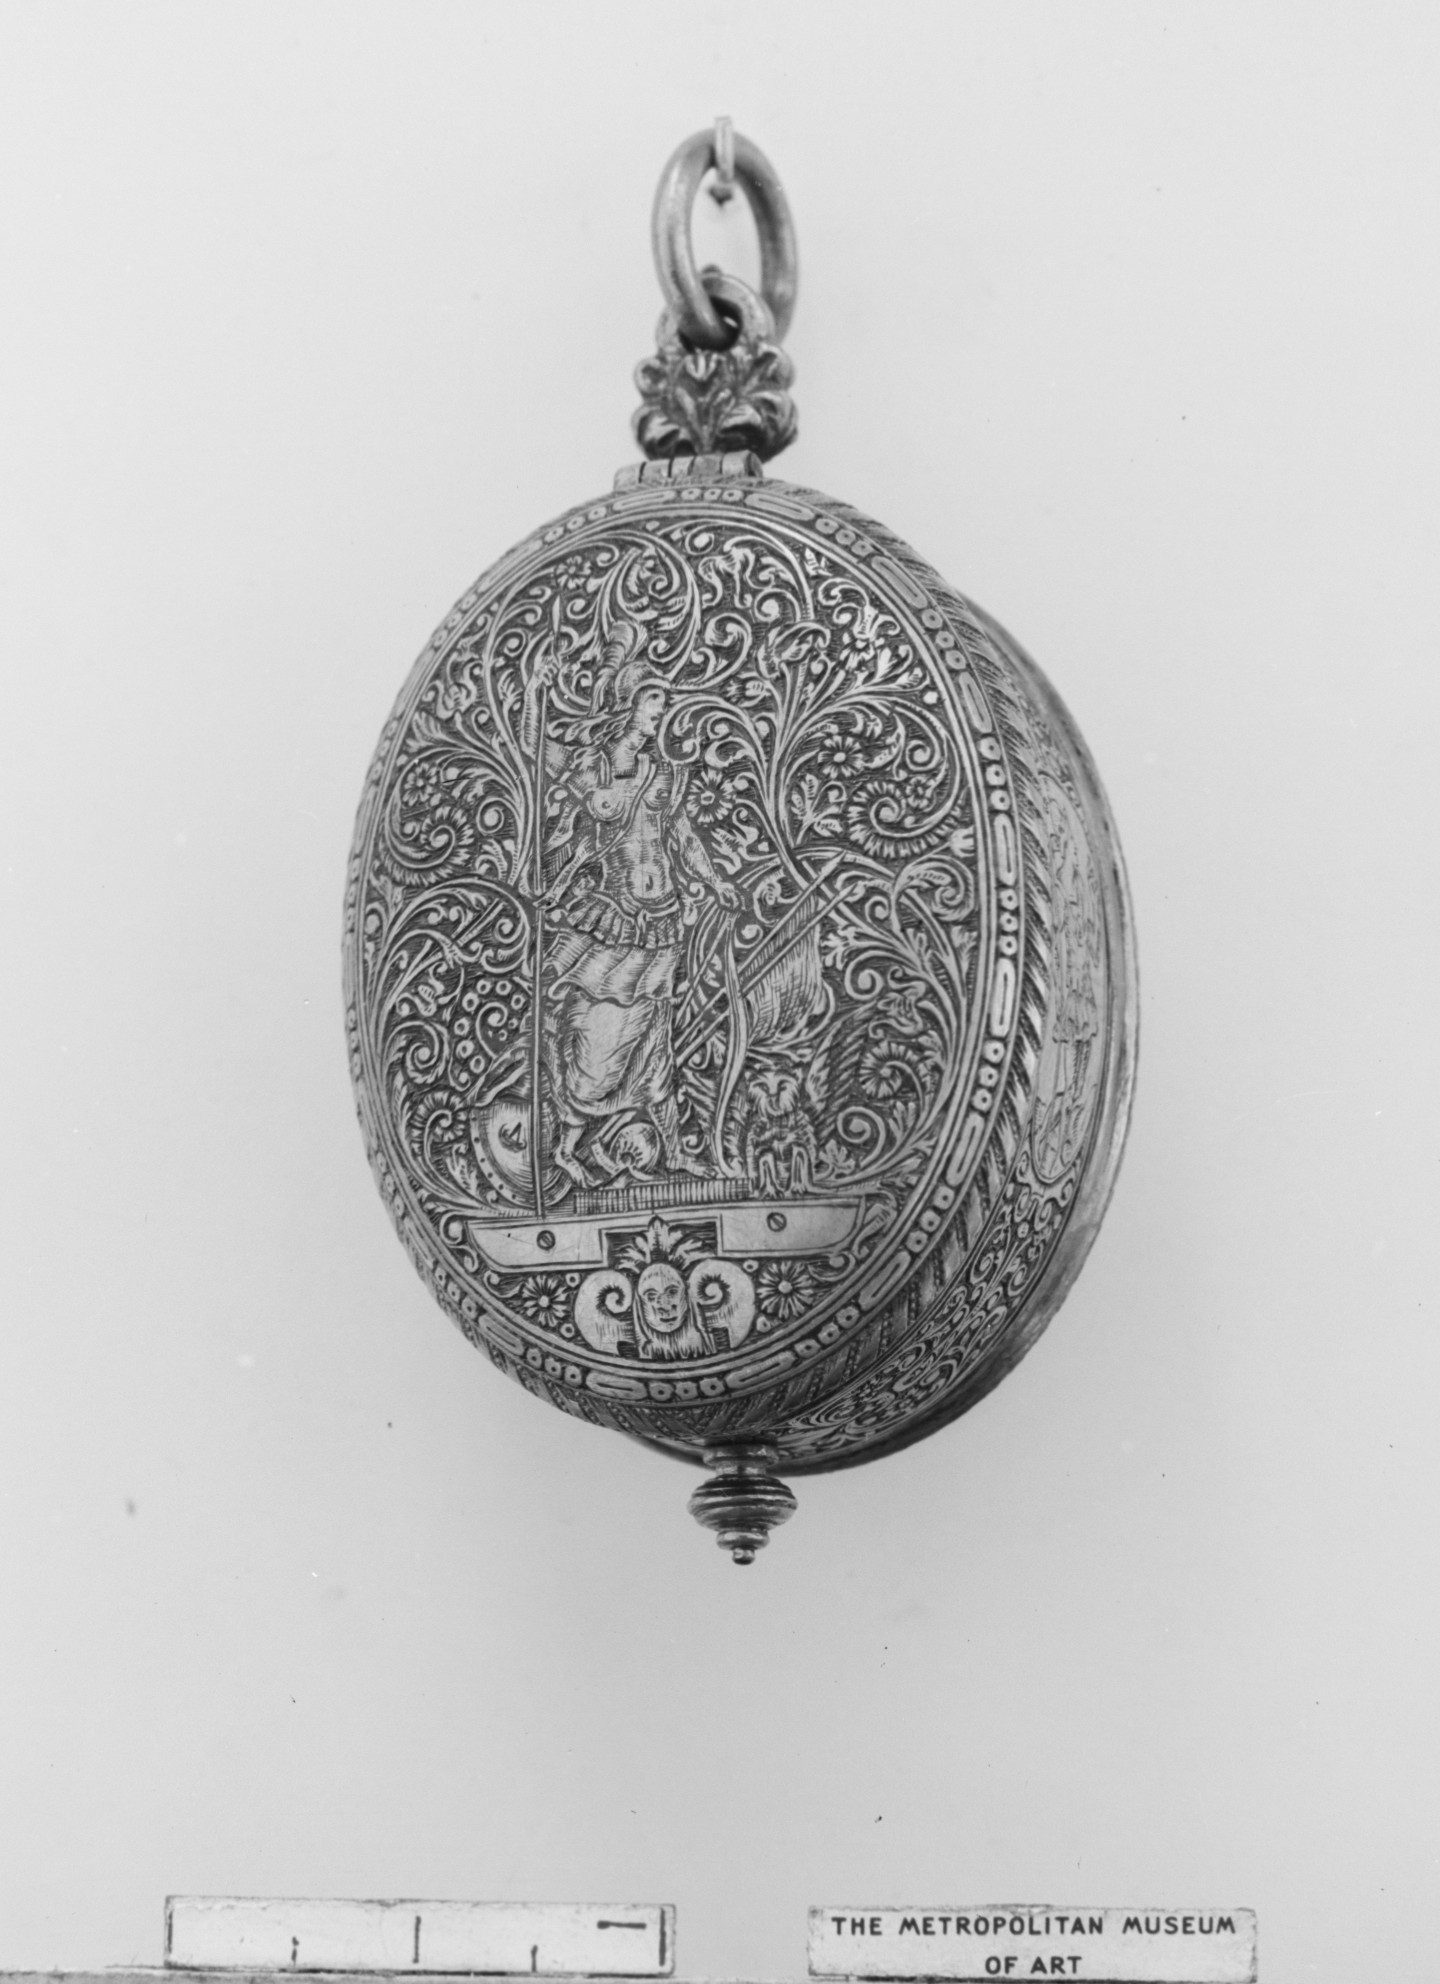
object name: watch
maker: nicolas galliard (or gaillard)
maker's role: artist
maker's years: 1502-1602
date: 1590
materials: silver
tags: faces,female nudes,flowers